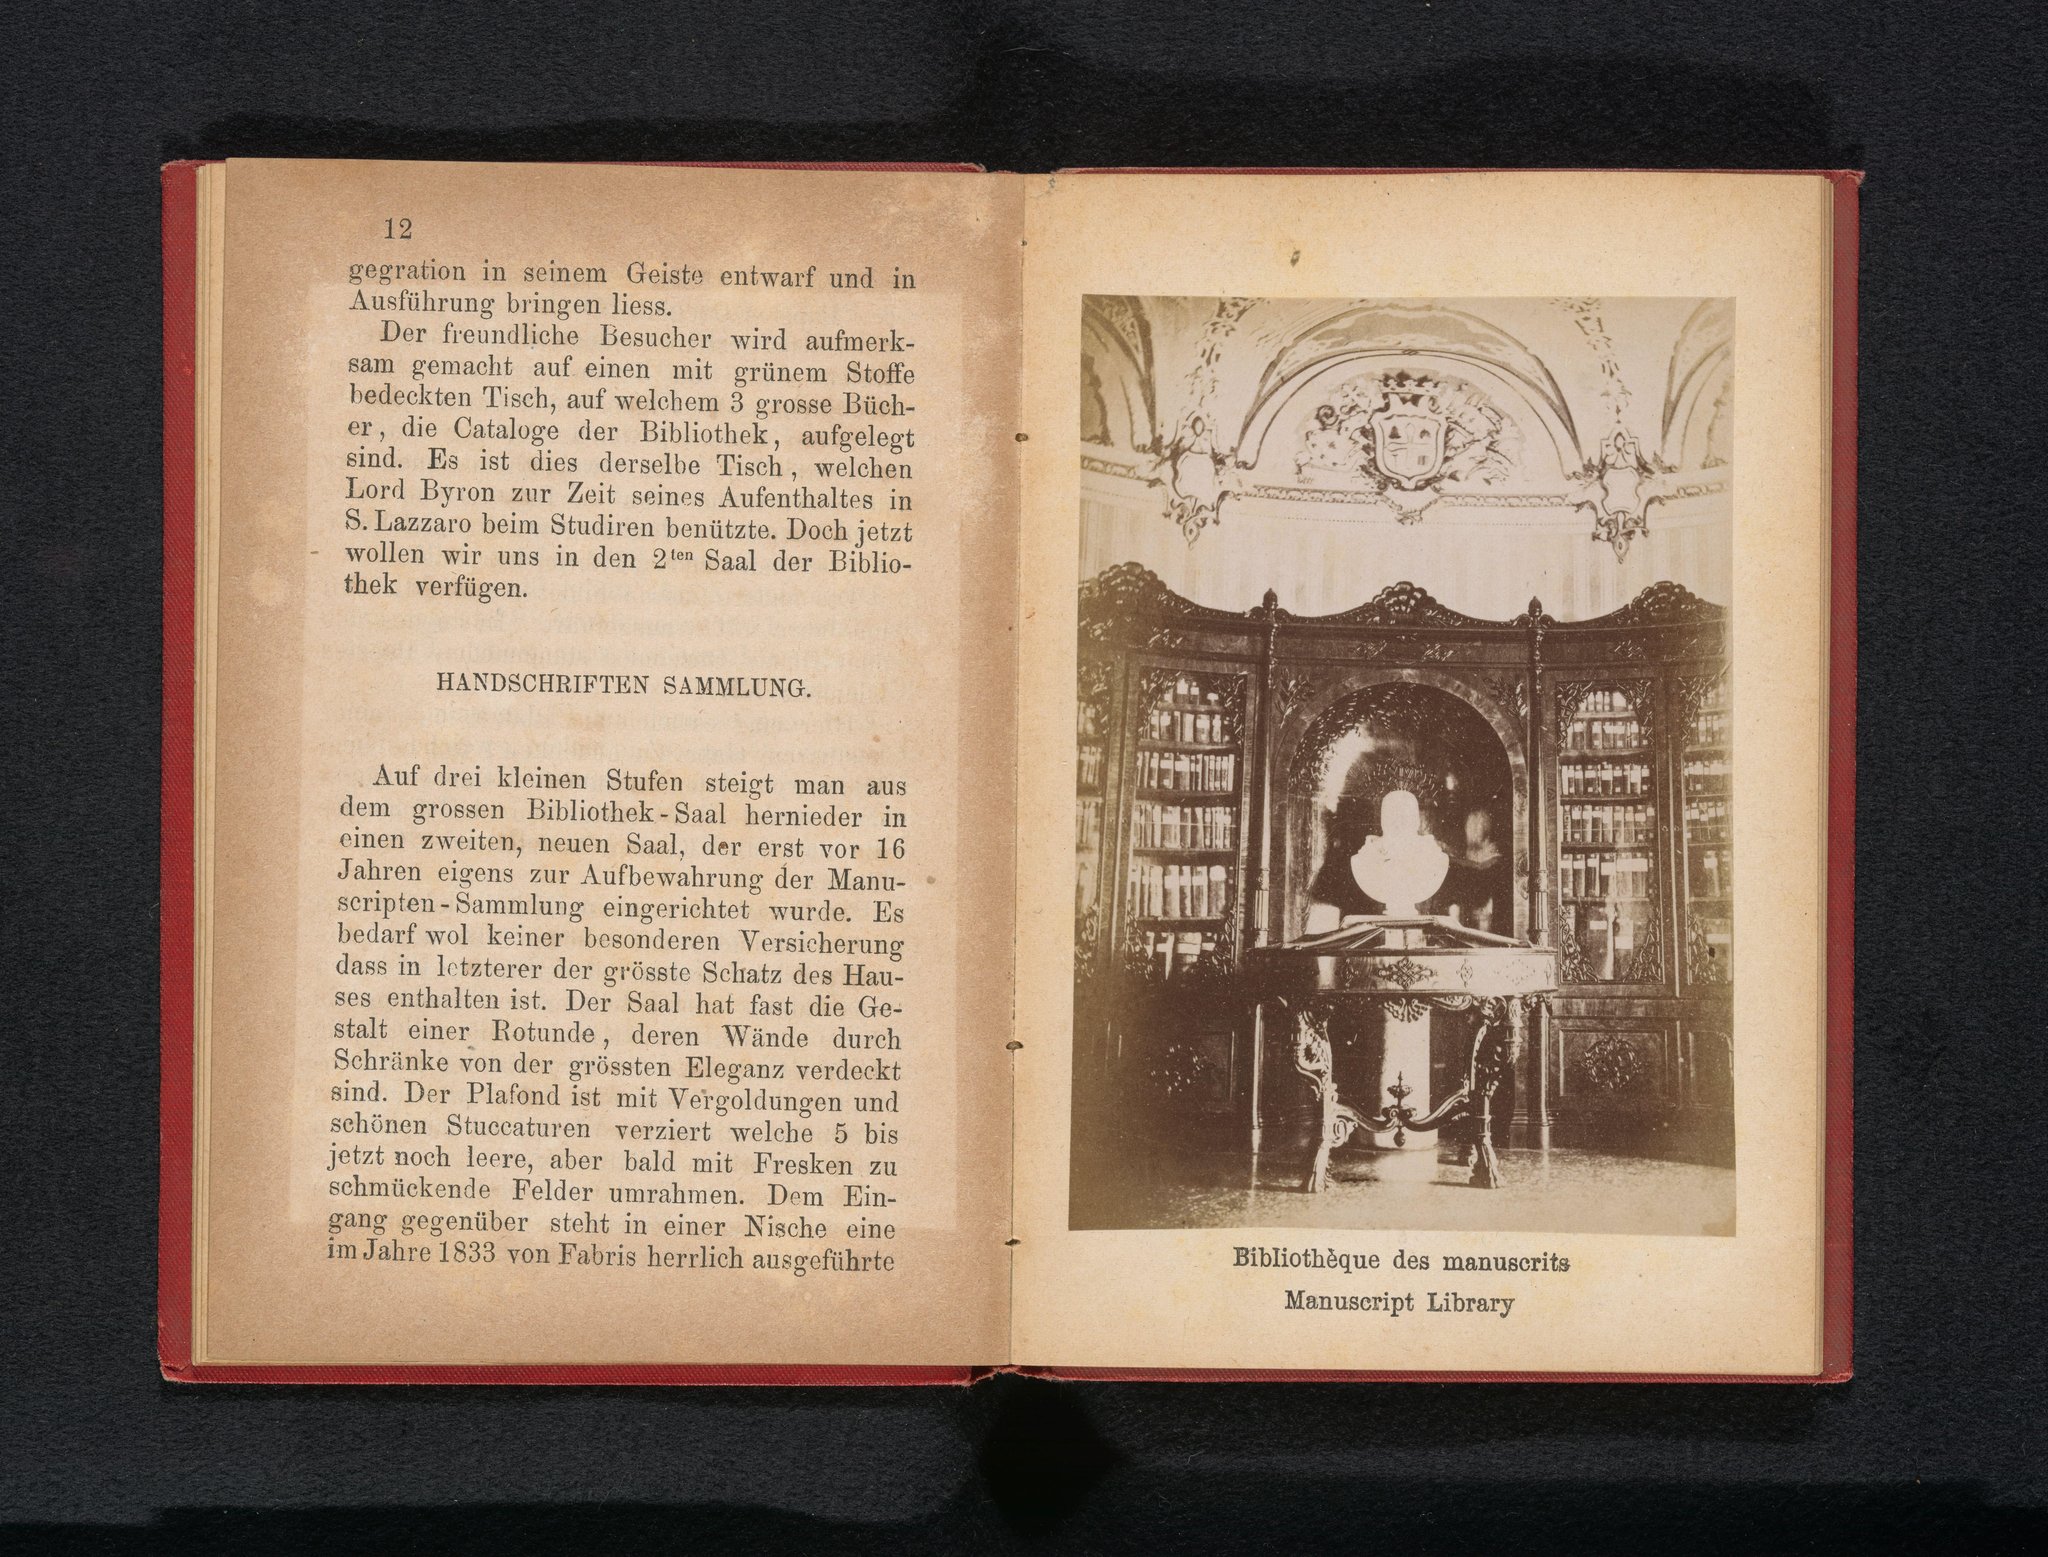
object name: page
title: Manuscript library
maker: Anonymous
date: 1870-1880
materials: paper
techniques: albumen print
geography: san lazzaro degli armeni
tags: abbey, monastery, convent ~ roman catholic church, public library